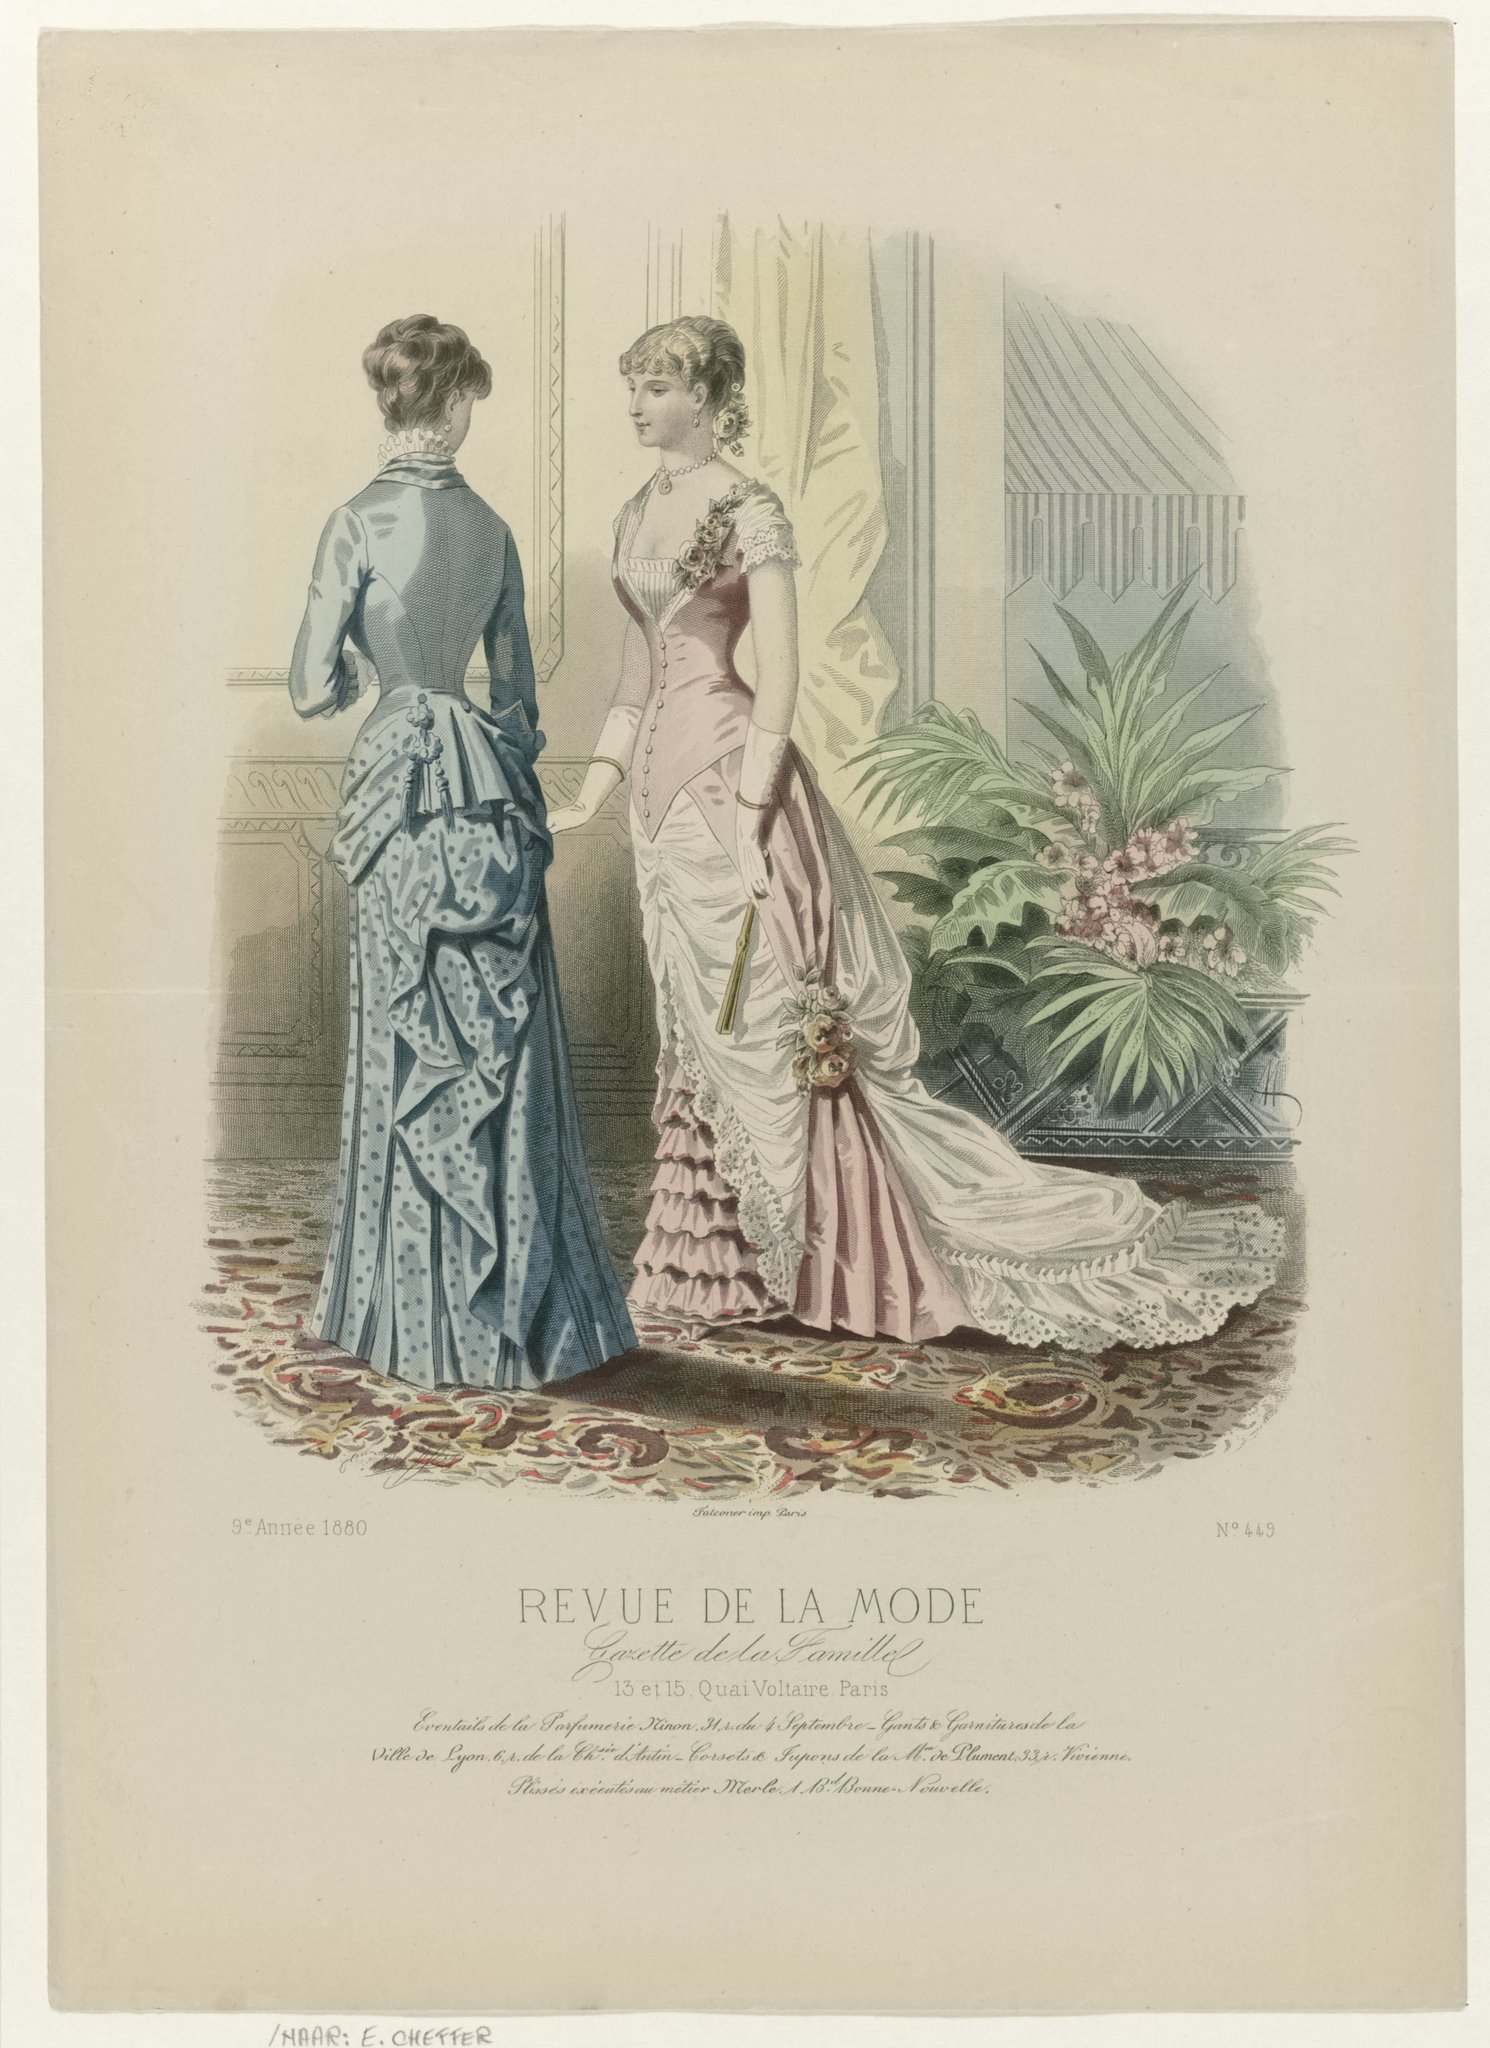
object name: fashion print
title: Revue de la Mode, Gazette de la Famille, dimanche 8 août 1880, 9e année, No. 449: Eventails de la Parfumerie Ninon (...)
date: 1880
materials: paper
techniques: engraving, hand coloring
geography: paris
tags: corsage (+ women's clothes), flowers, pendant, trinket, 'breloque' (+ women's clothes), gloves, mittens (long gloves) (+ women's clothes), dress, gown: ball gown (+ women's clothes), dress, gown: dinner dress (+ women's clothes), fashion plates, dress, gown (+ women's clothes), bracelet, wristlet (+ women's clothes)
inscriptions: title: ‘REVUE DE LA MODE / Gazette de la Famille’, caption: ‘Eventails de la Parfumerie Ninon, 31, r. du 4 Septembre_ Gants & Garnitures de la Ville de Lyon, 6. r. de la Ch.sée d'Antin_Corsets & Jupons de la M.on de Plument, 33, r. Vivienne. Plissés exécutés au métier Merle, 1, B.d Bonne-Nouvelle.’, address: ‘13 et 15, Quai Voltaire, Paris’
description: Twee vrouwen in een interieur. Links: japon van effen en gebrocheerde 'surah' in blauw. Rechts: baljapon, ook geschikt voor 'grand diner', van roze satijn en witte crêpe de chine of 'mousseline blanche indienne'. Met vouwwaaier. Onder de afbeelding enkele regels reclametekst voor verschillende producten. Prent uit het modetijdschrift Revue de la Mode (1872-1913). Uitgebreide beschrijving van de kleding op pagina 267 "PLANCHE COLORIÉE".